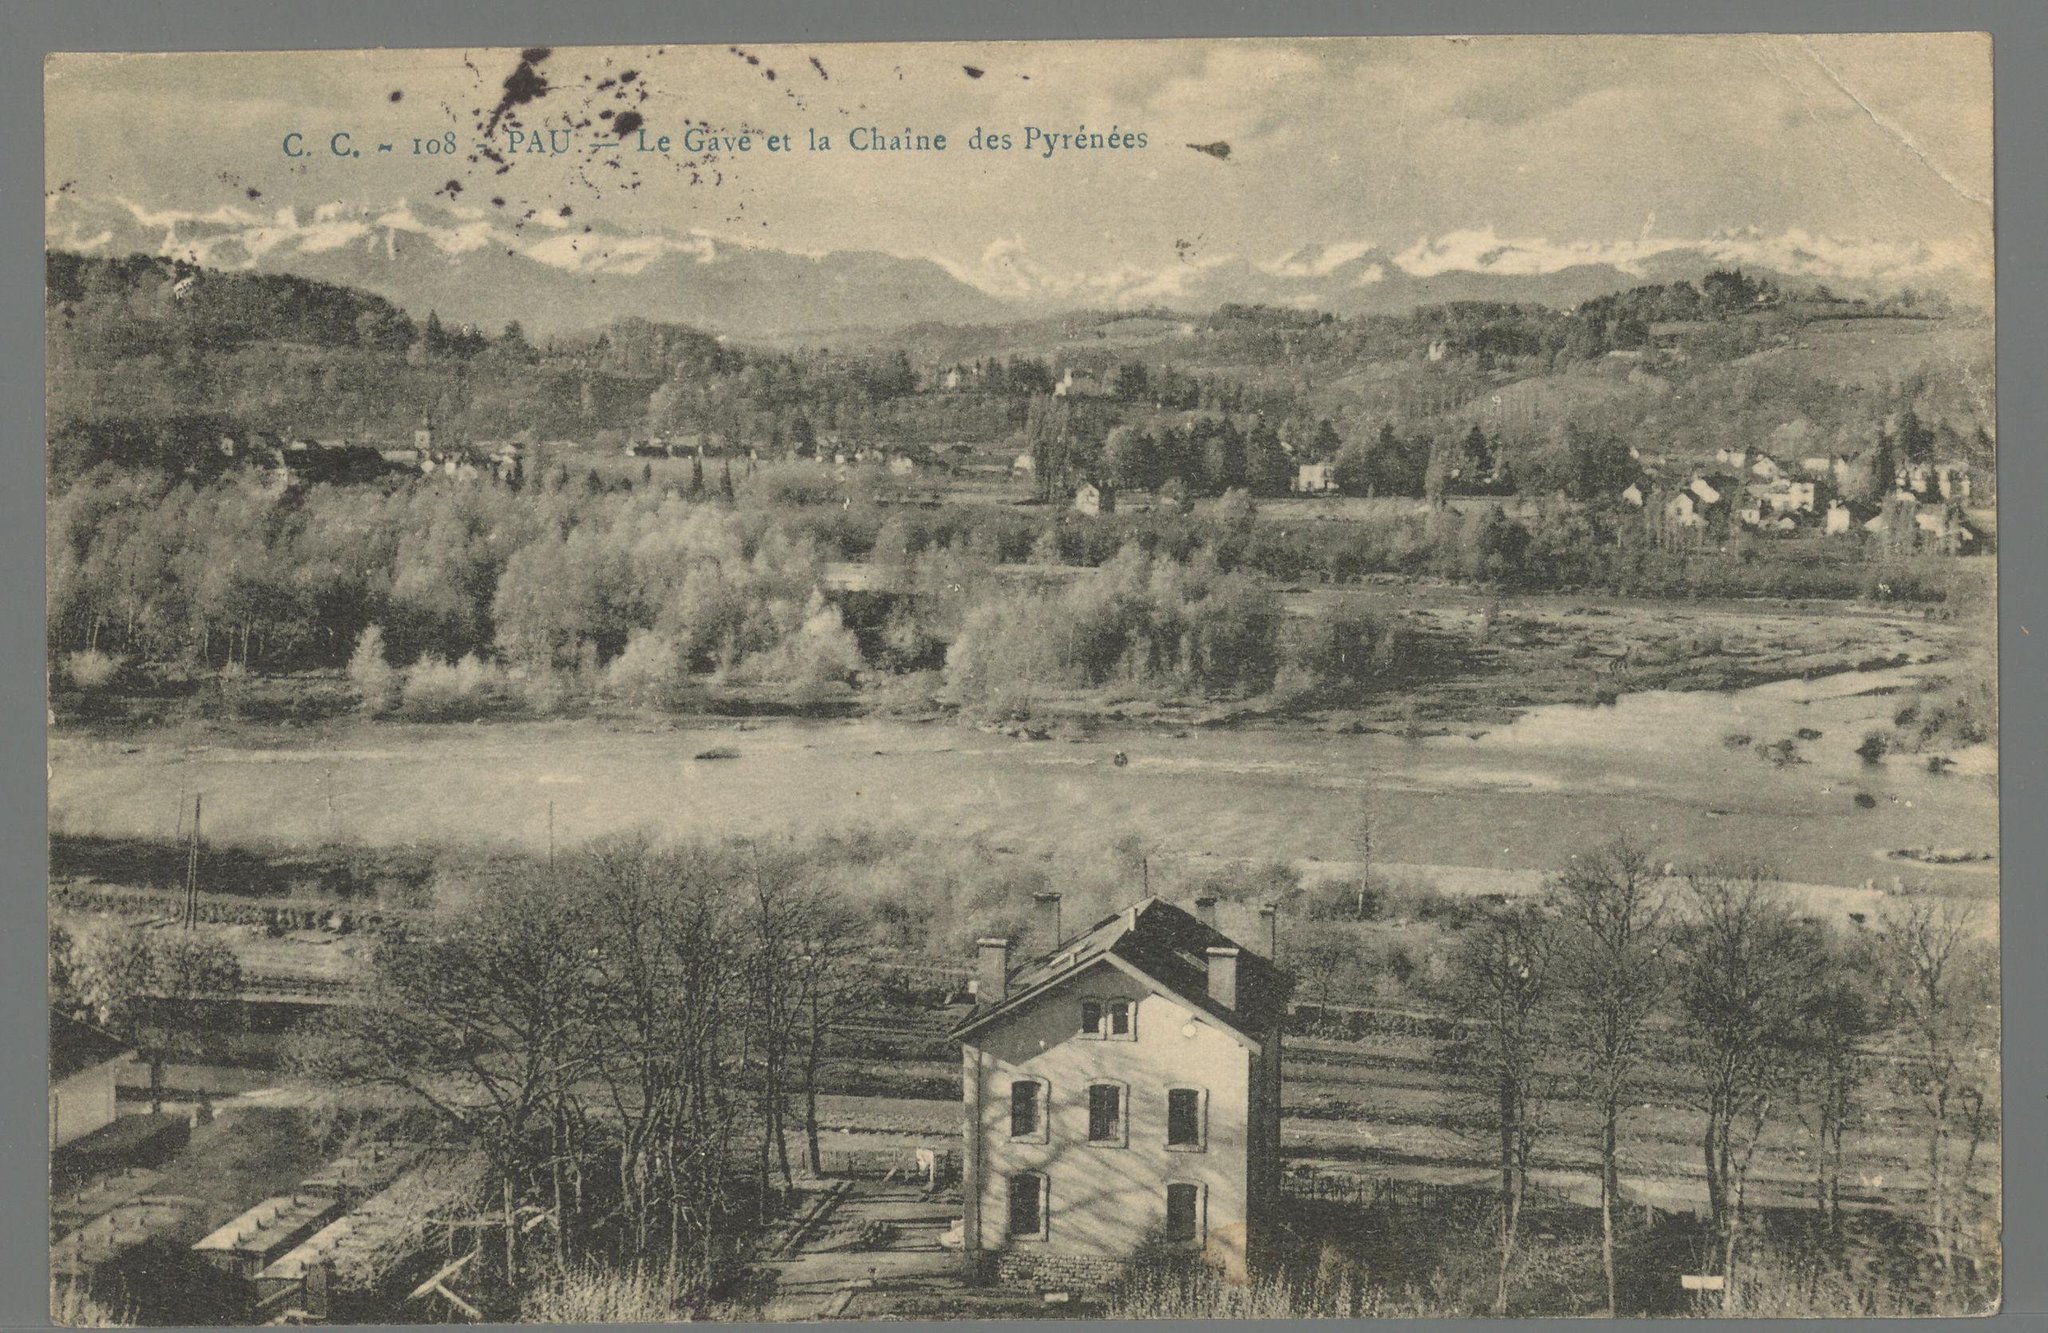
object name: photomechanical print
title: Pau. Le Gave et la Chaîne des Pyrenées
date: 1903-1910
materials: cardboard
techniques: photograph, writing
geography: pau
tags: river, landscapes in the temperate zone, rural housing, e.g. country-house, villa, cottage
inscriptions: postage stamp